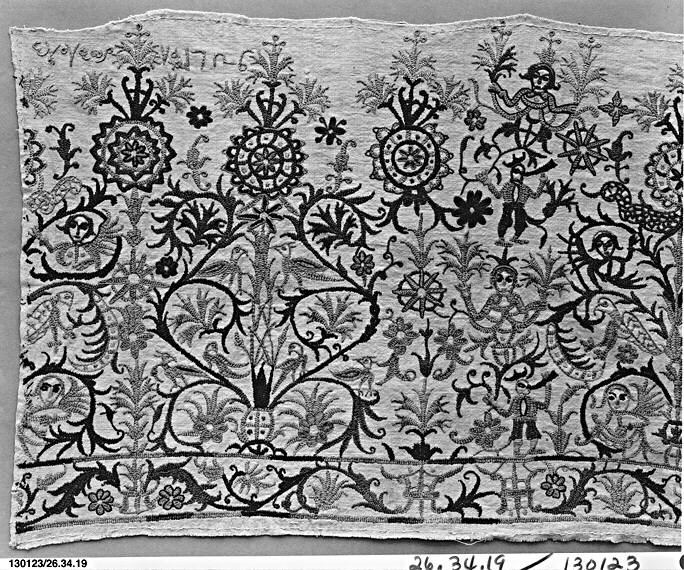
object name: border fragment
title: Portion of a dress border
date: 1726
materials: linen, silk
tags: human figures